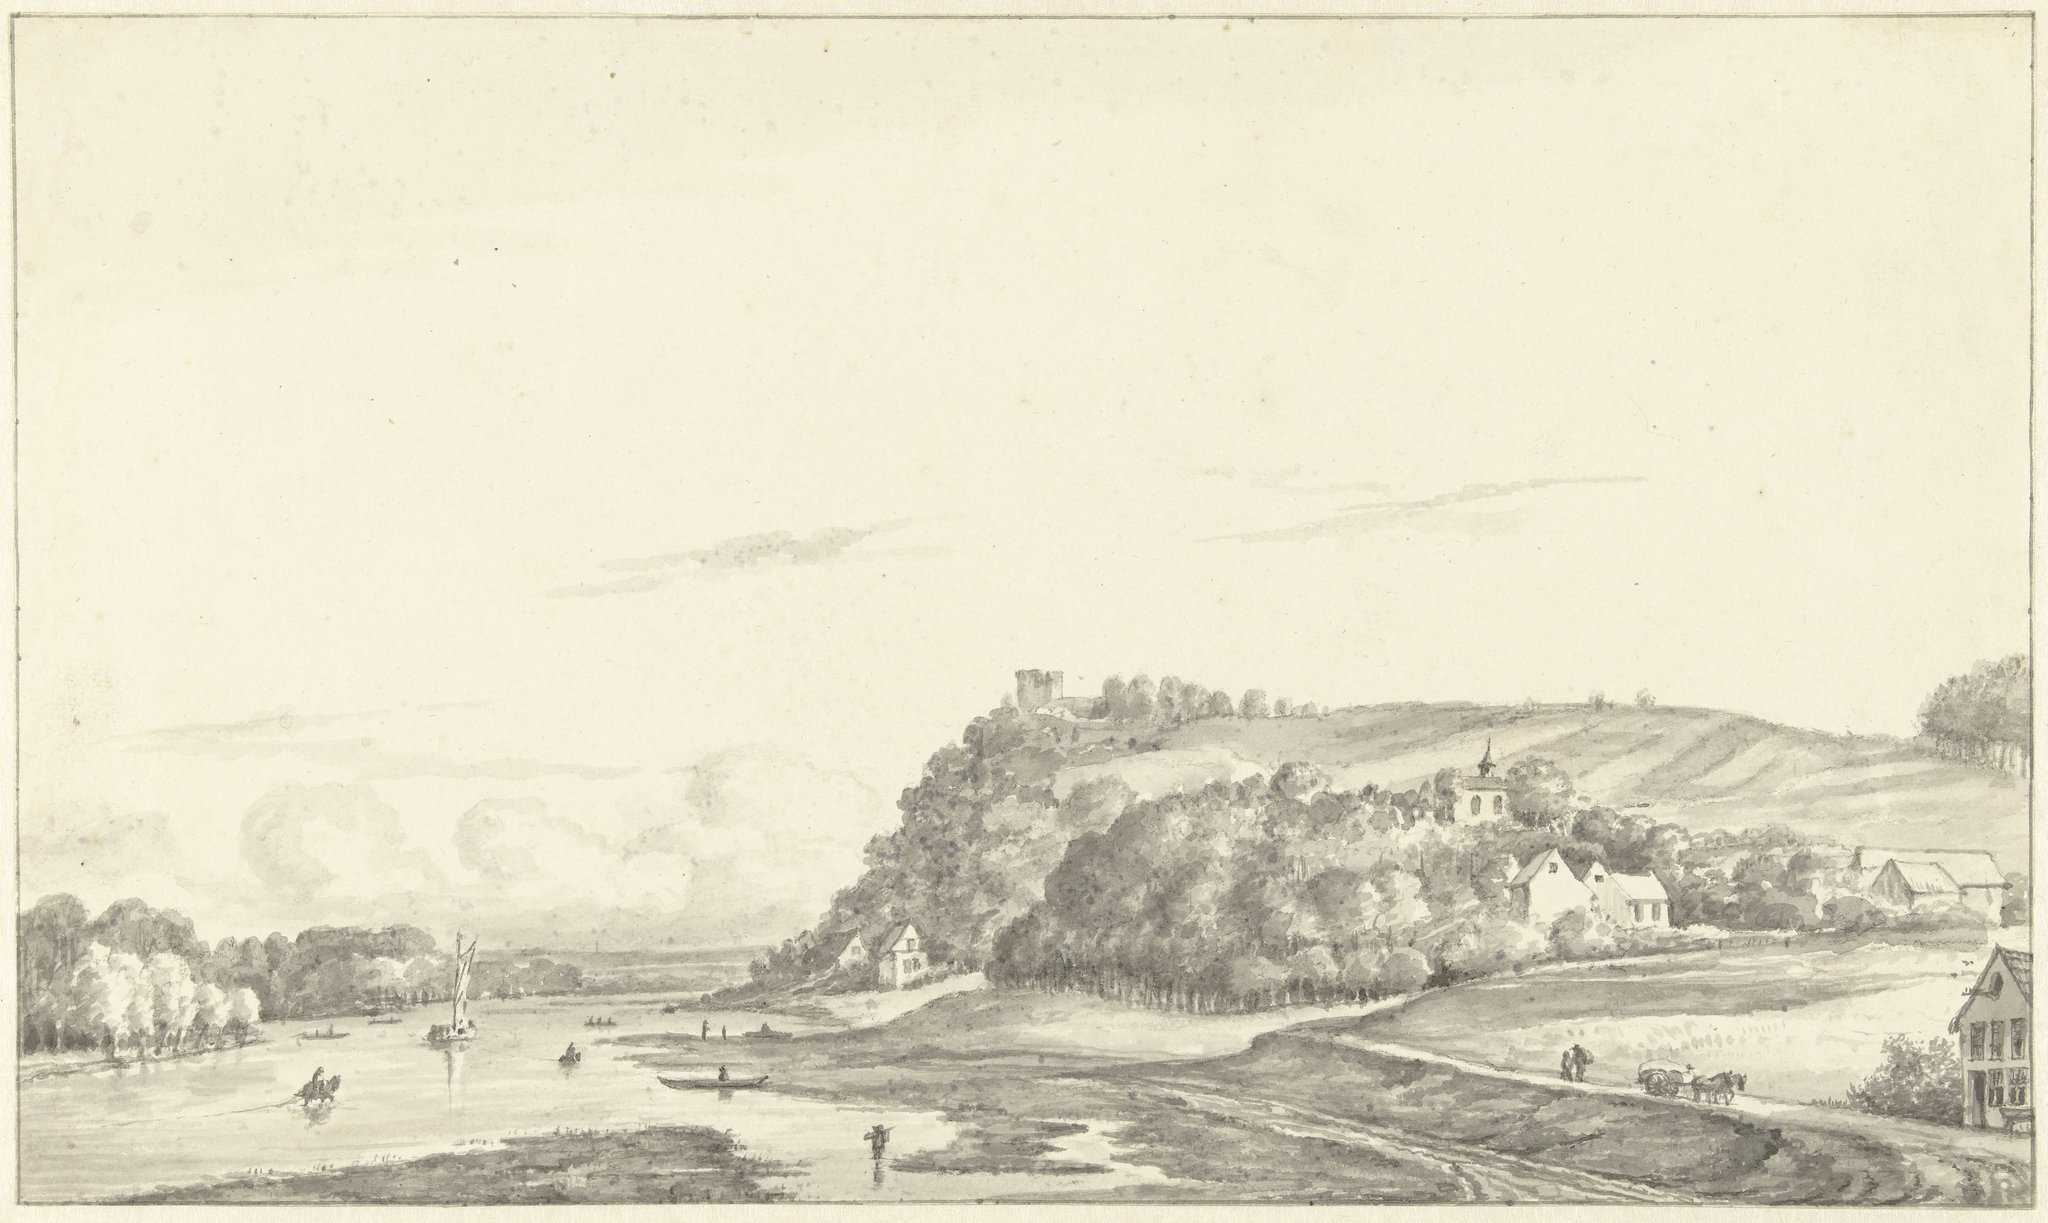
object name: drawing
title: St. Pietersberg aan de Maas, van Maastricht te zien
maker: gerrit lamberts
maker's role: bookseller, draughtsman, print maker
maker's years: 1776-1850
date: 1826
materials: chalk, paper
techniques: brush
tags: mountains